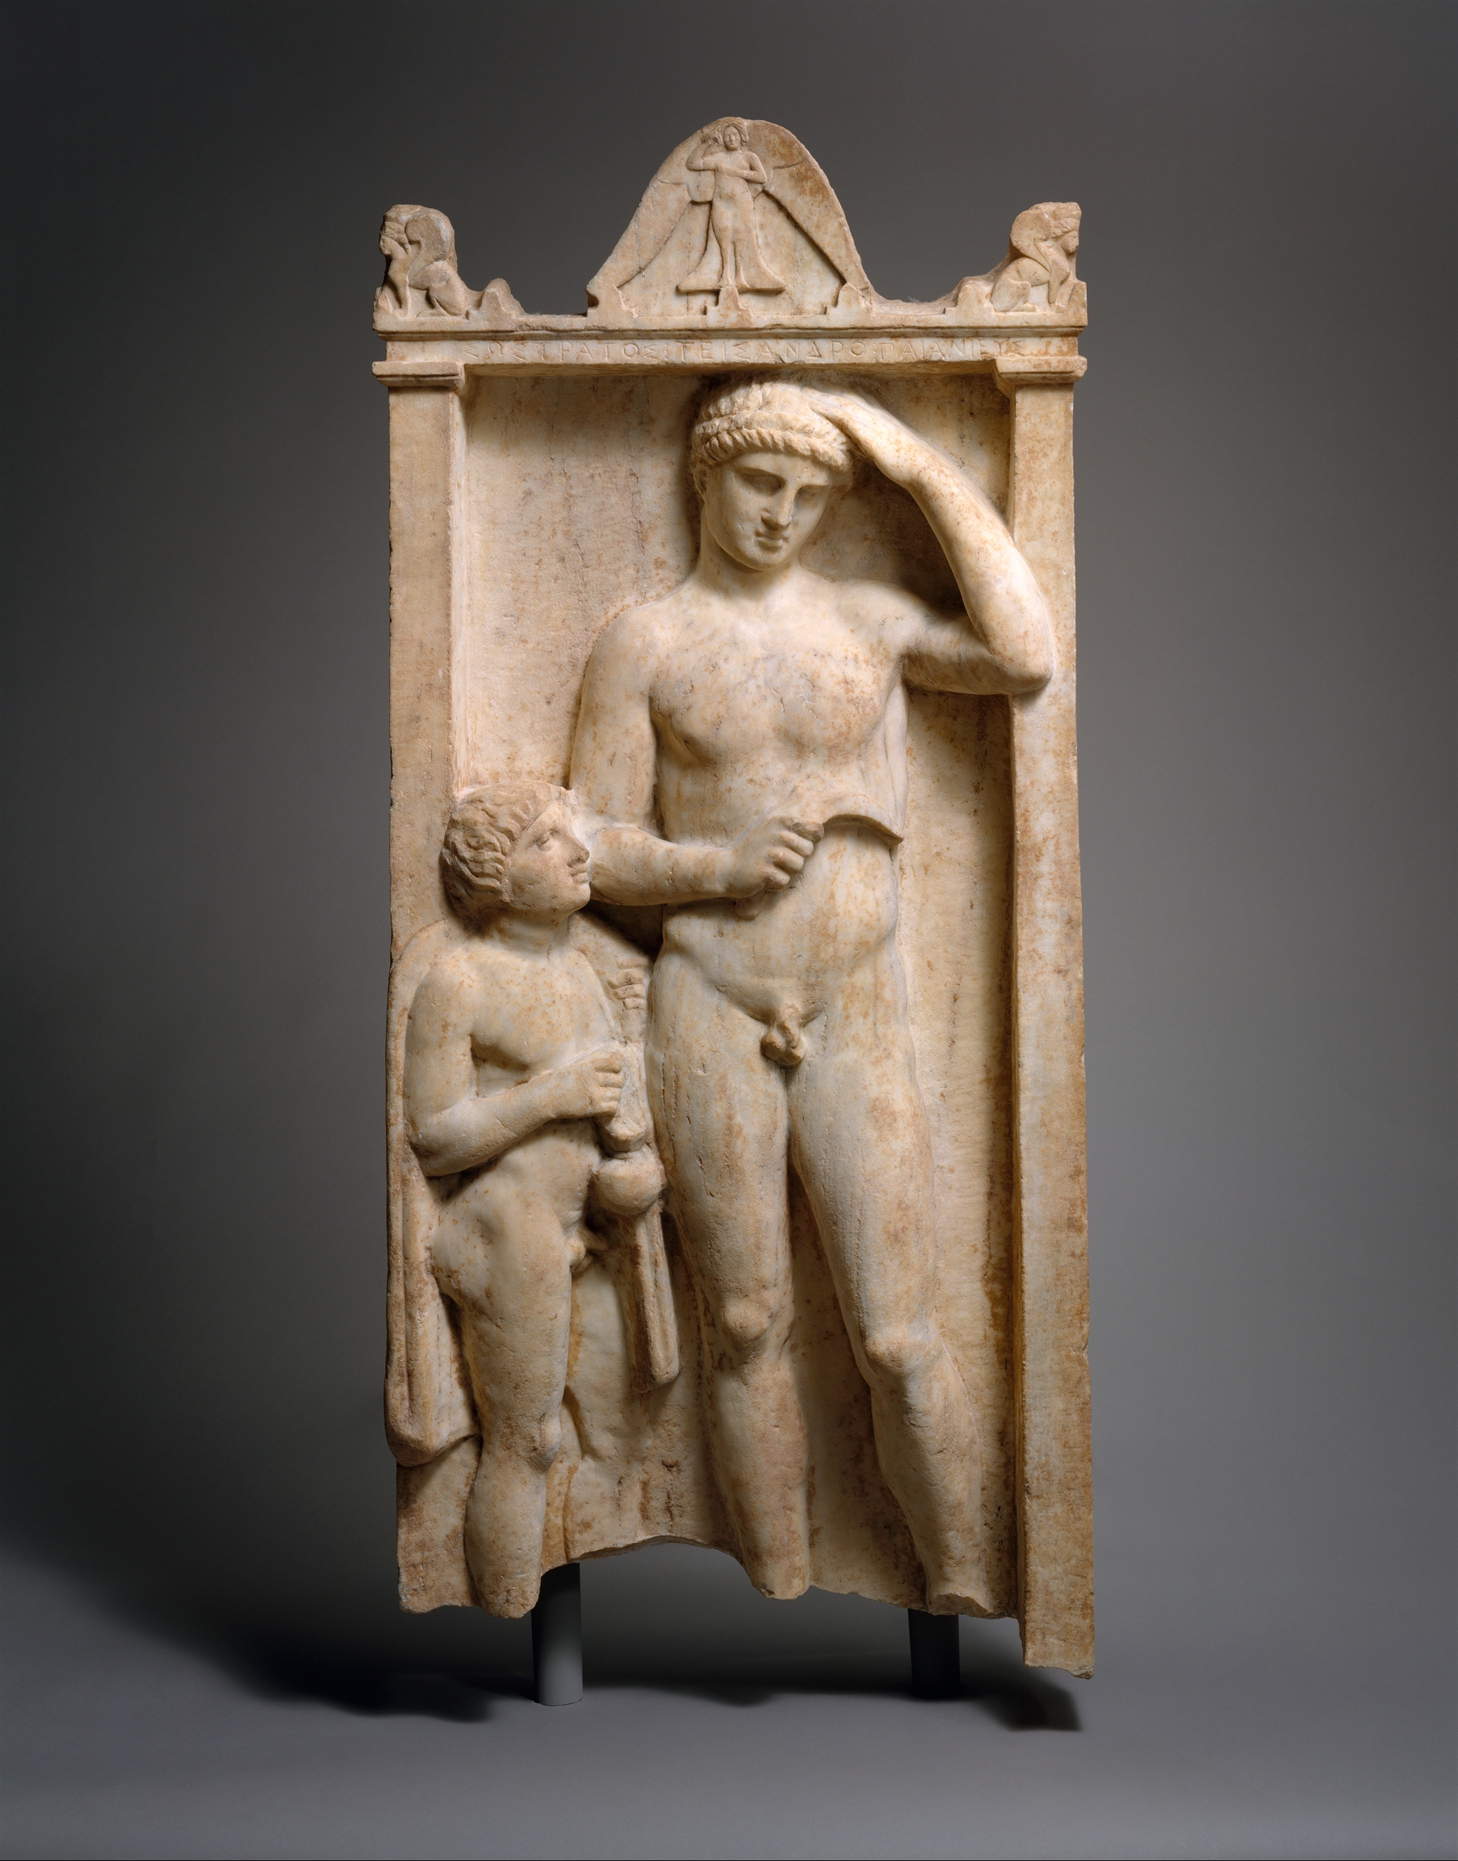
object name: grave stele of sostratos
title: Marble stele (grave marker) of Sostratos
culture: greek, attic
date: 375-350 BCE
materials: marble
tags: boys,male nudes